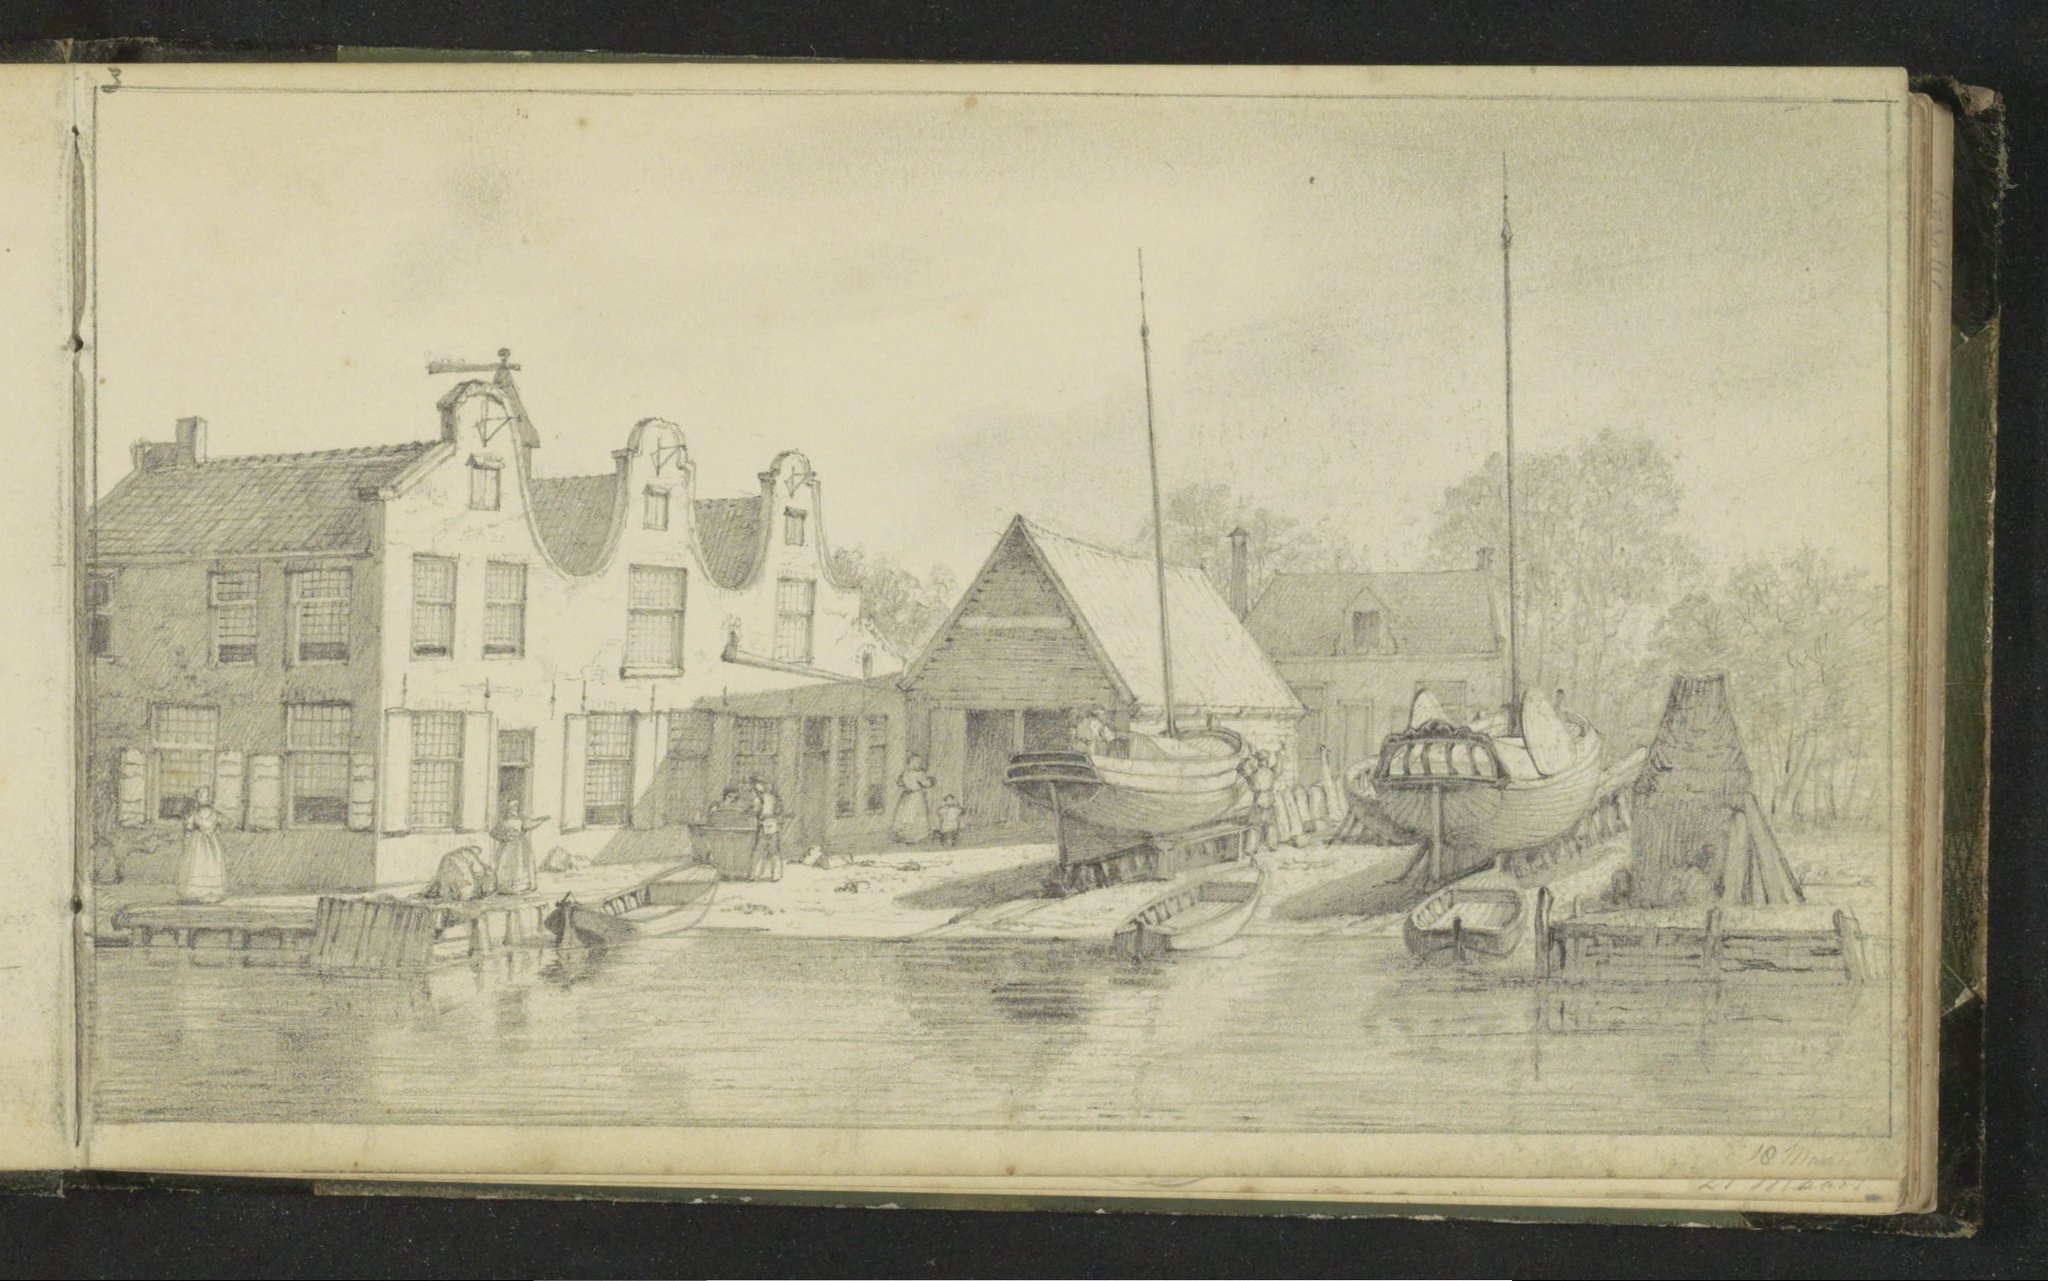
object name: sketchbook leaf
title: Scheepswerf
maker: hendrik abraham klinkhamer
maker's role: draughtsman, painter, print maker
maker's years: 1810-1872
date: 1803-1843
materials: paper, pencil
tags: shipyard, shipdock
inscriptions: date: ‘18 Maart [...]’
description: Tekening in een kader. Blad 3 recto uit een schetsboek met 40 bladen.